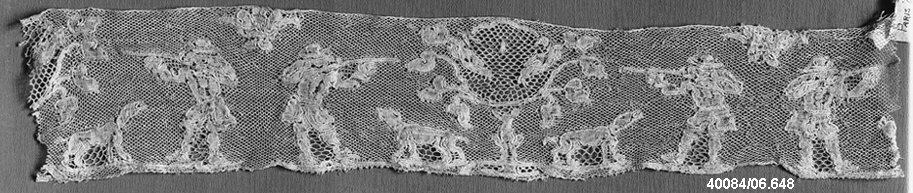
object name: piece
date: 1701-1800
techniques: lace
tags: men,hunting,dogs